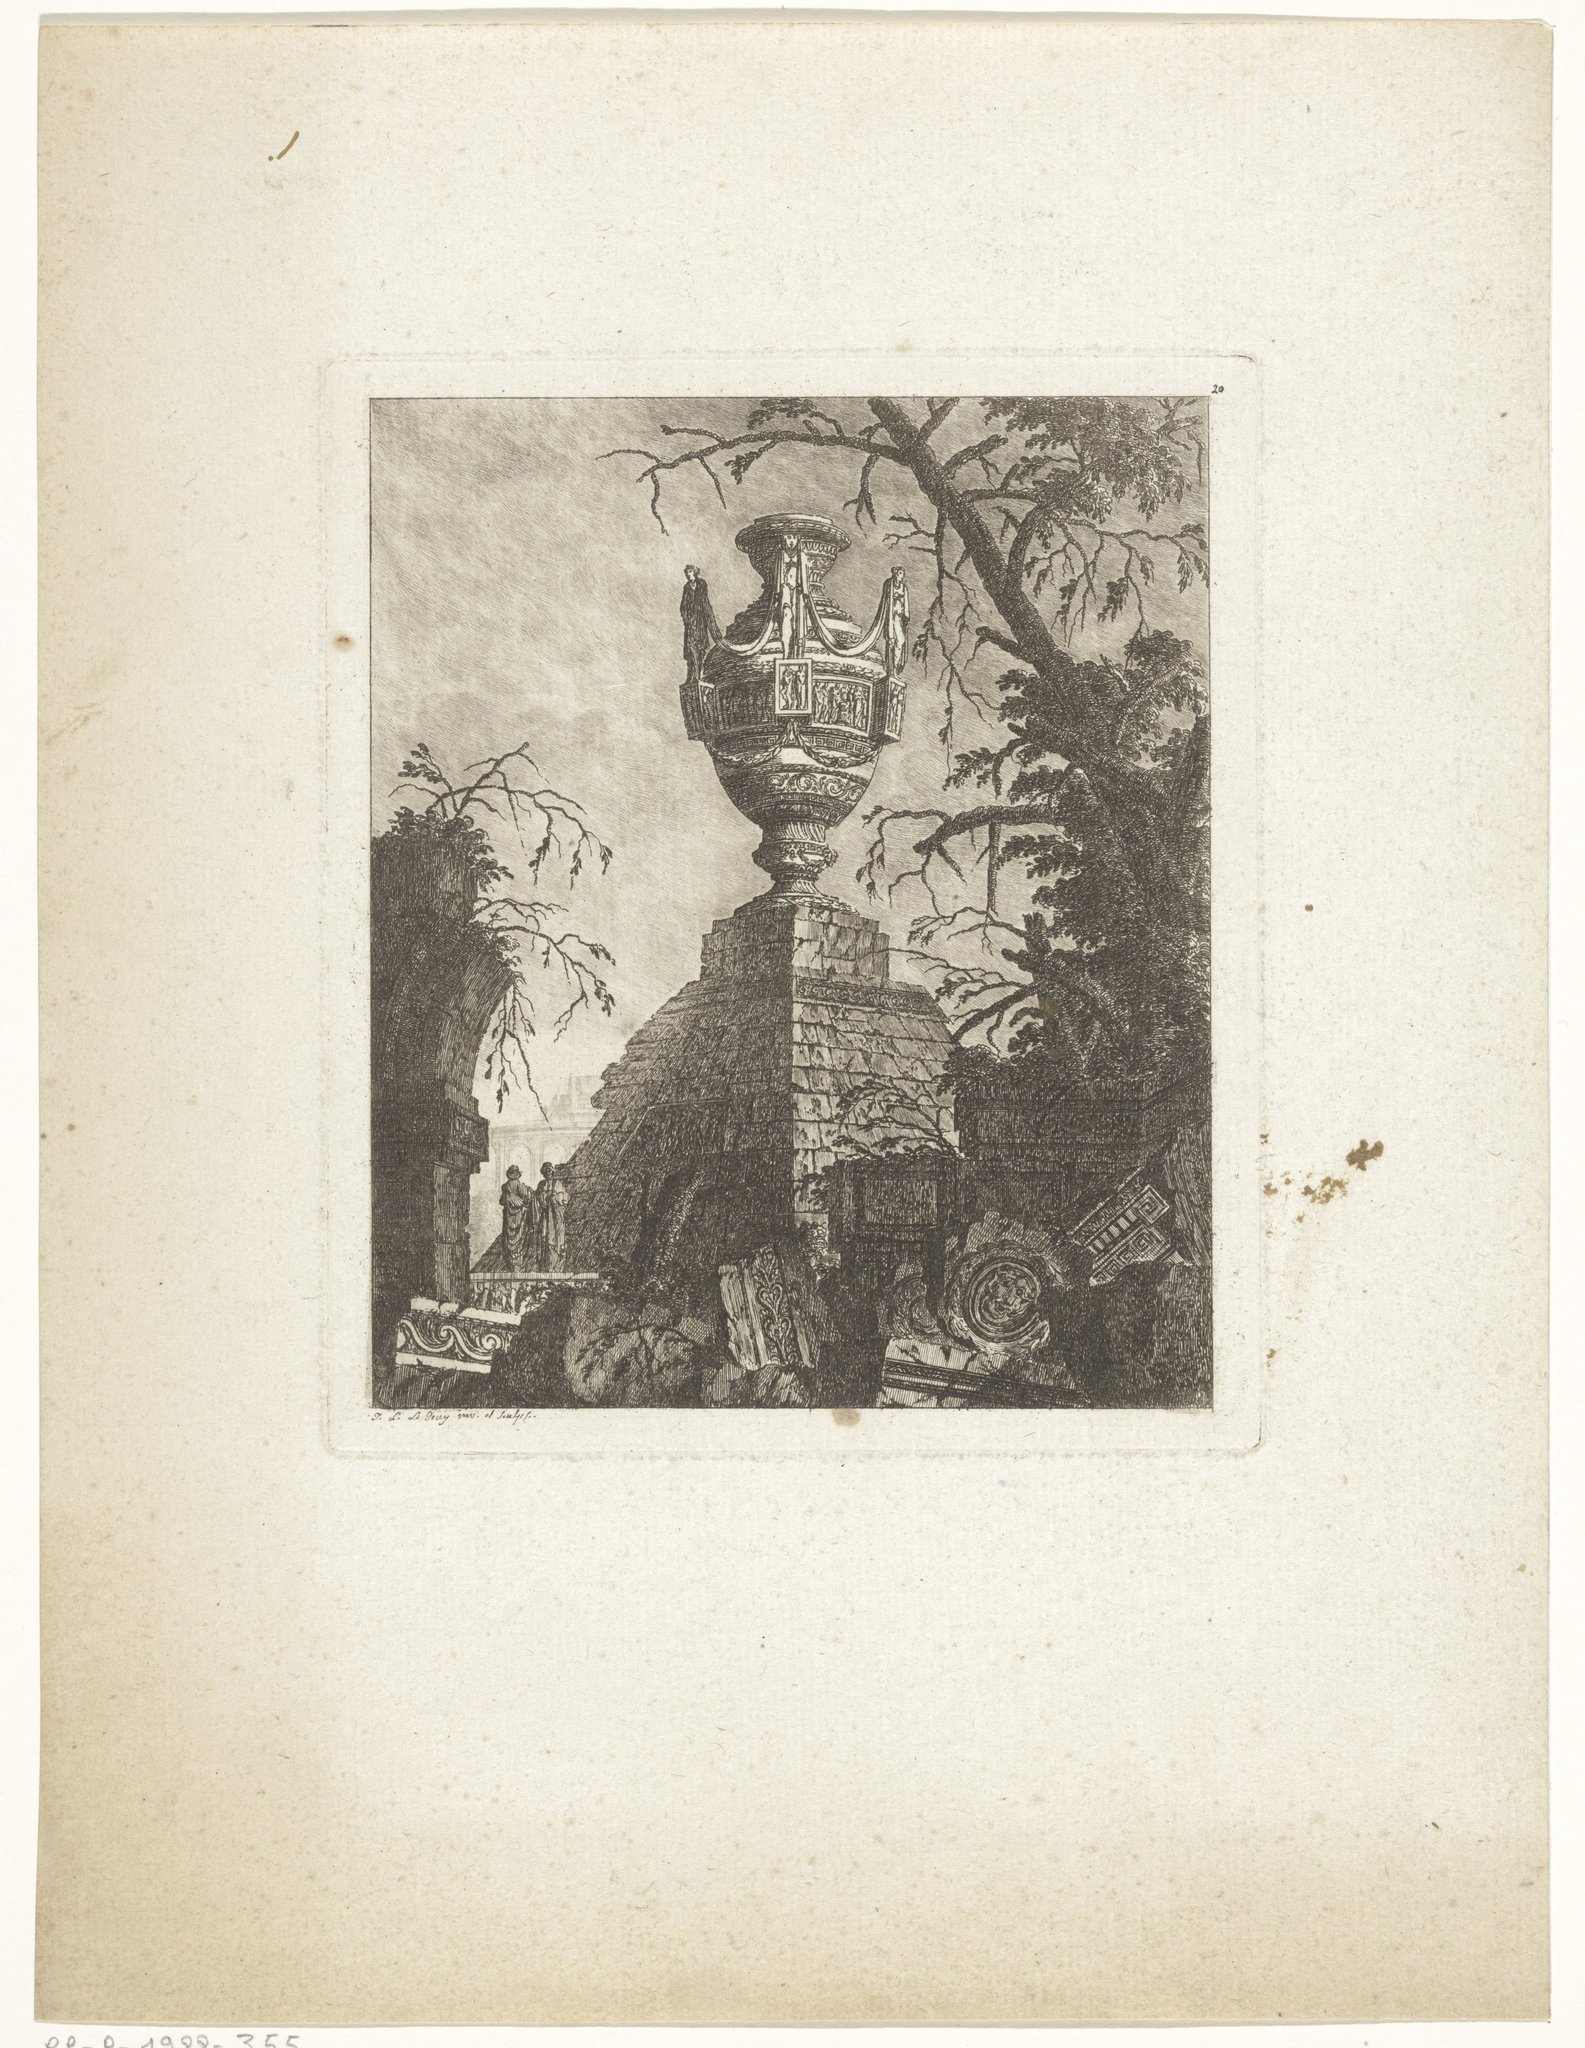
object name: print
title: Architectuurfantasie, blad 20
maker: jean laurent legeay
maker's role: print maker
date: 1767-1768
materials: paper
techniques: etching